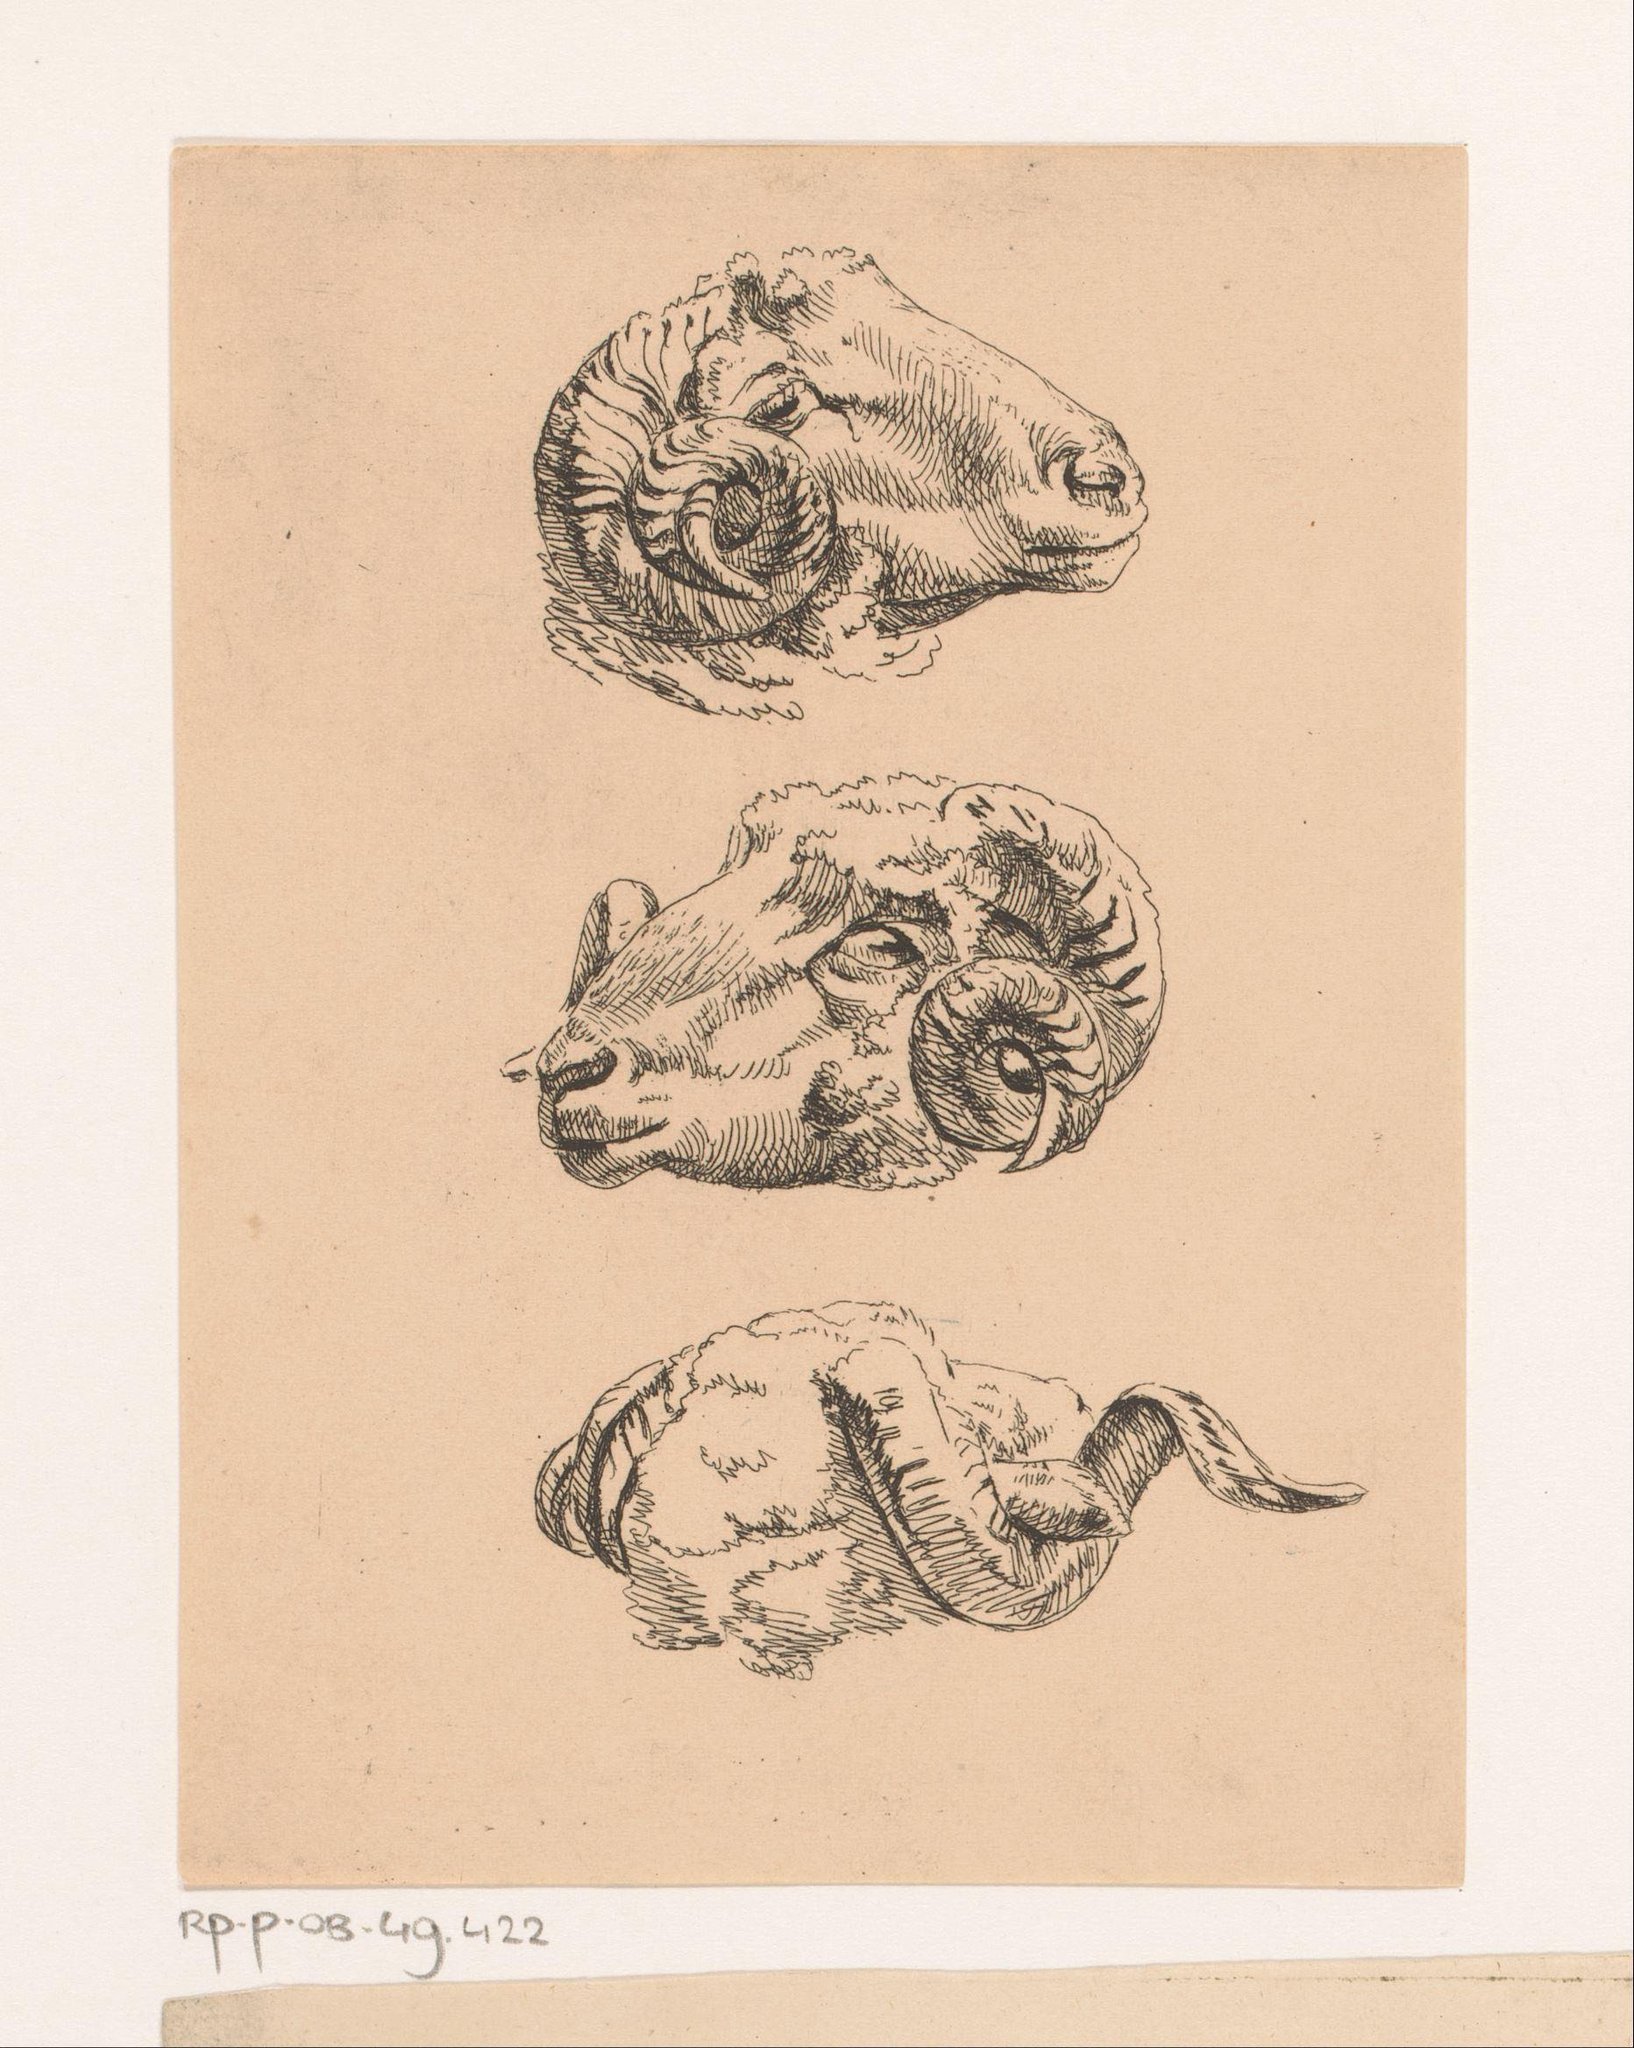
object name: print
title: Drie ramskoppen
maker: hendrik jozef franciscus van der poorten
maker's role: draughtsman, print maker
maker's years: 1789-1874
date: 1840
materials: paper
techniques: etching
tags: ram's head ~ ornament, ram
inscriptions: annotation: ‘H. van der Poorten voor de naam’, collector's mark: Lugt 2228